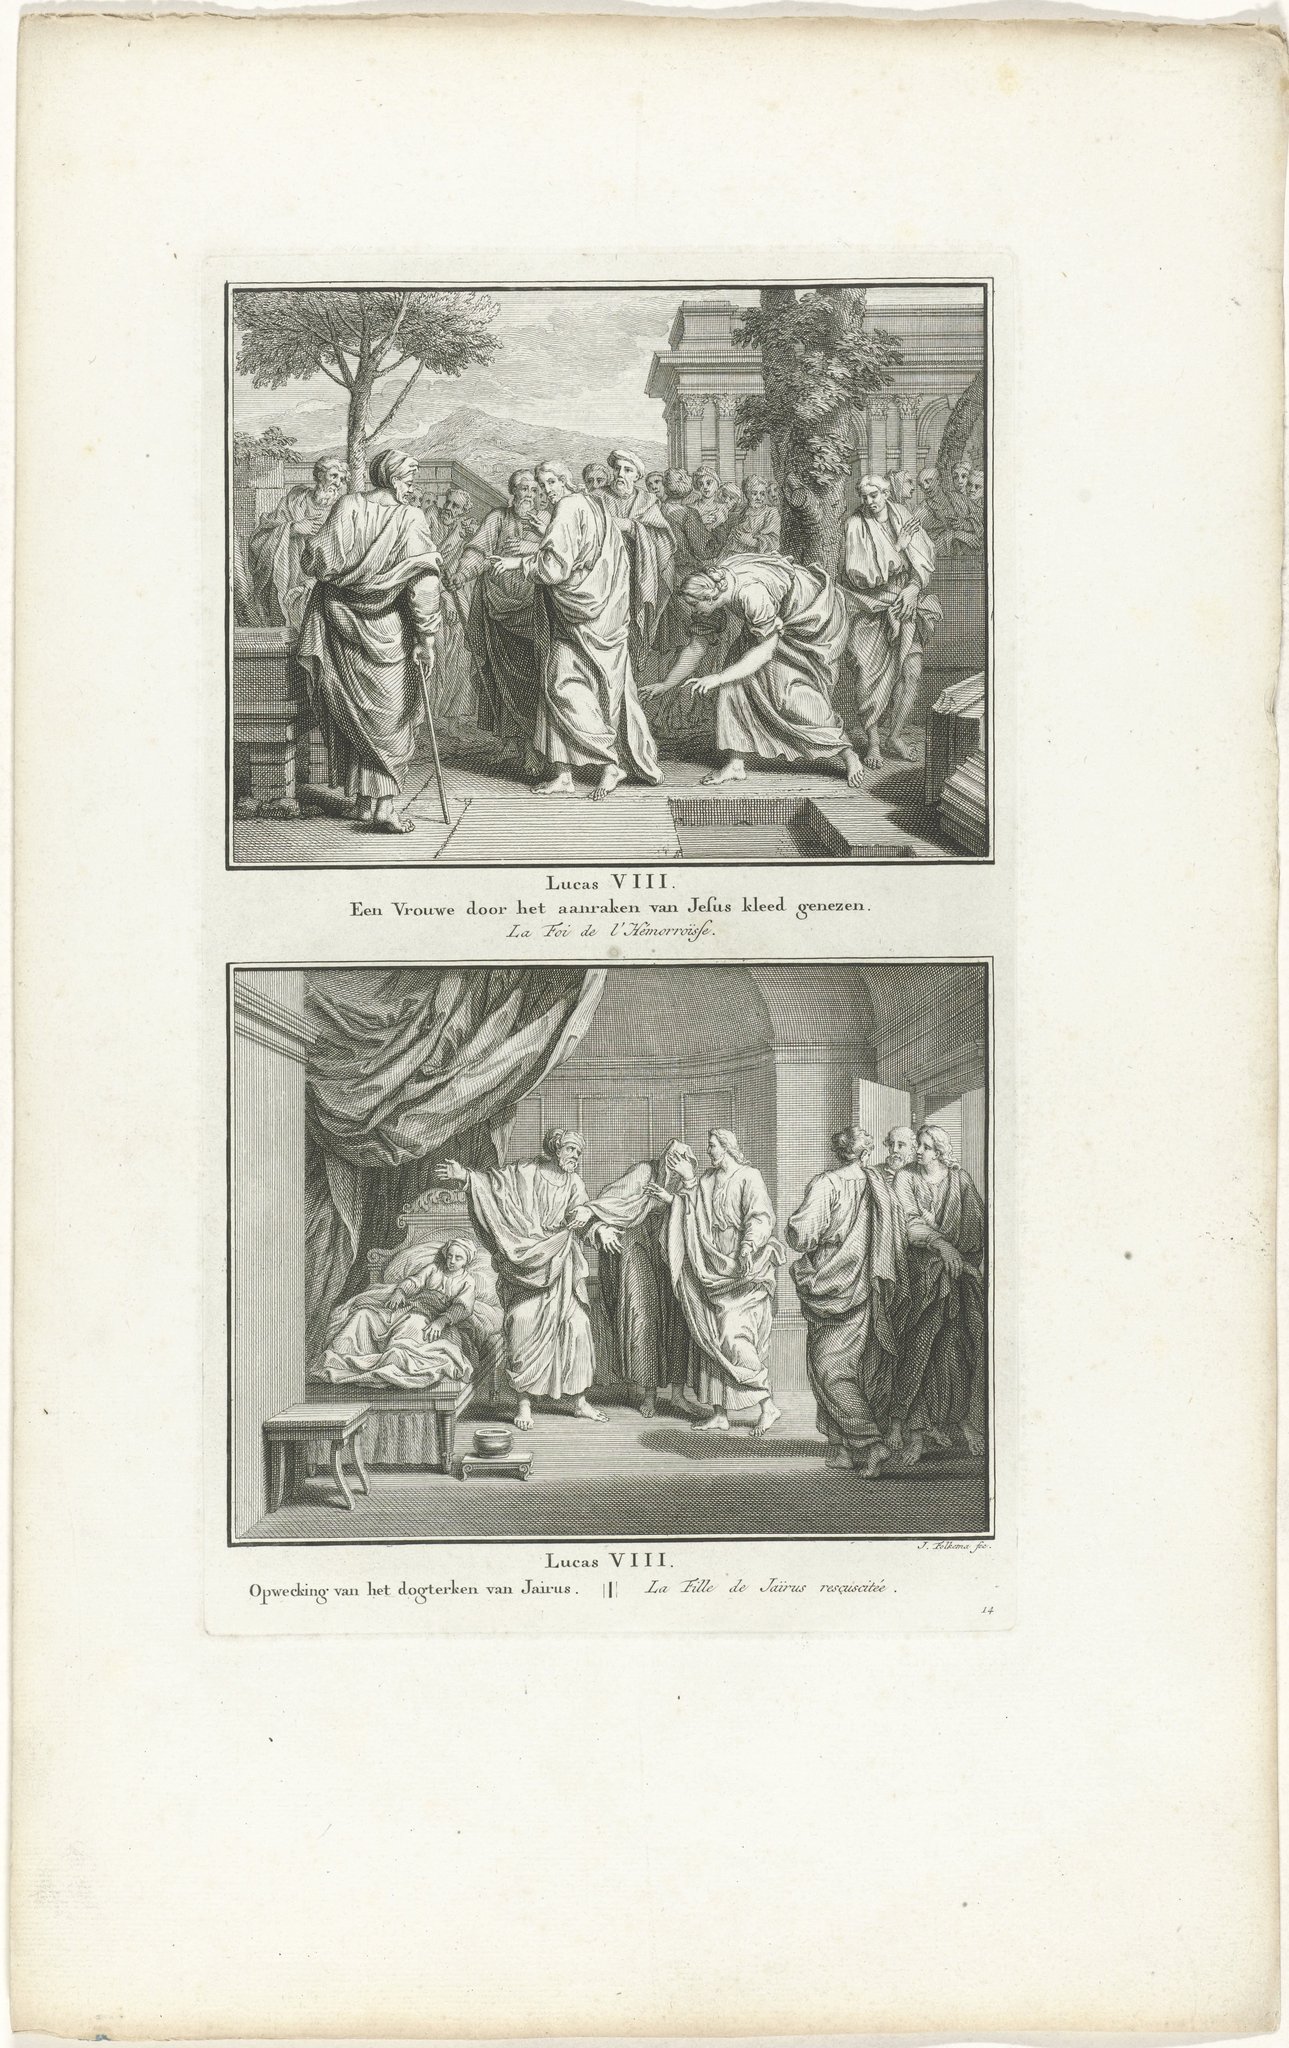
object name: book illustration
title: Genezing van de vrouw die aan bloedvloeiingen leed en Christus wekt de dochter van Jaïrus op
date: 1791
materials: paper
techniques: etching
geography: dordrecht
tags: raising of the daughter of jairus, who is lying in bed (matthew 9:18-19, 9:23-26; mark 5:21-24, 5:35-43; luke 8:40-42, 8:49-56), healing of a woman with an issue of blood: she kneels before christ after having touched his robe (matthew 9:20-22; mark 5:25-34; luke 8:43-48)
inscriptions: collector's mark: Lugt 2233, collector's mark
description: Twee Bijbelse voorstellingen uit Luc. 8. Een vrouw geneest van haar bloedvloeiingen door het kleed van Christus aan te raken, en Christus geneest de dochter van Jaïrus. Twee voorstellingen van één plaat, elk voorzien van een titel in het Nederlands en Frans. Geheel rechtsonder genummerd: 14.